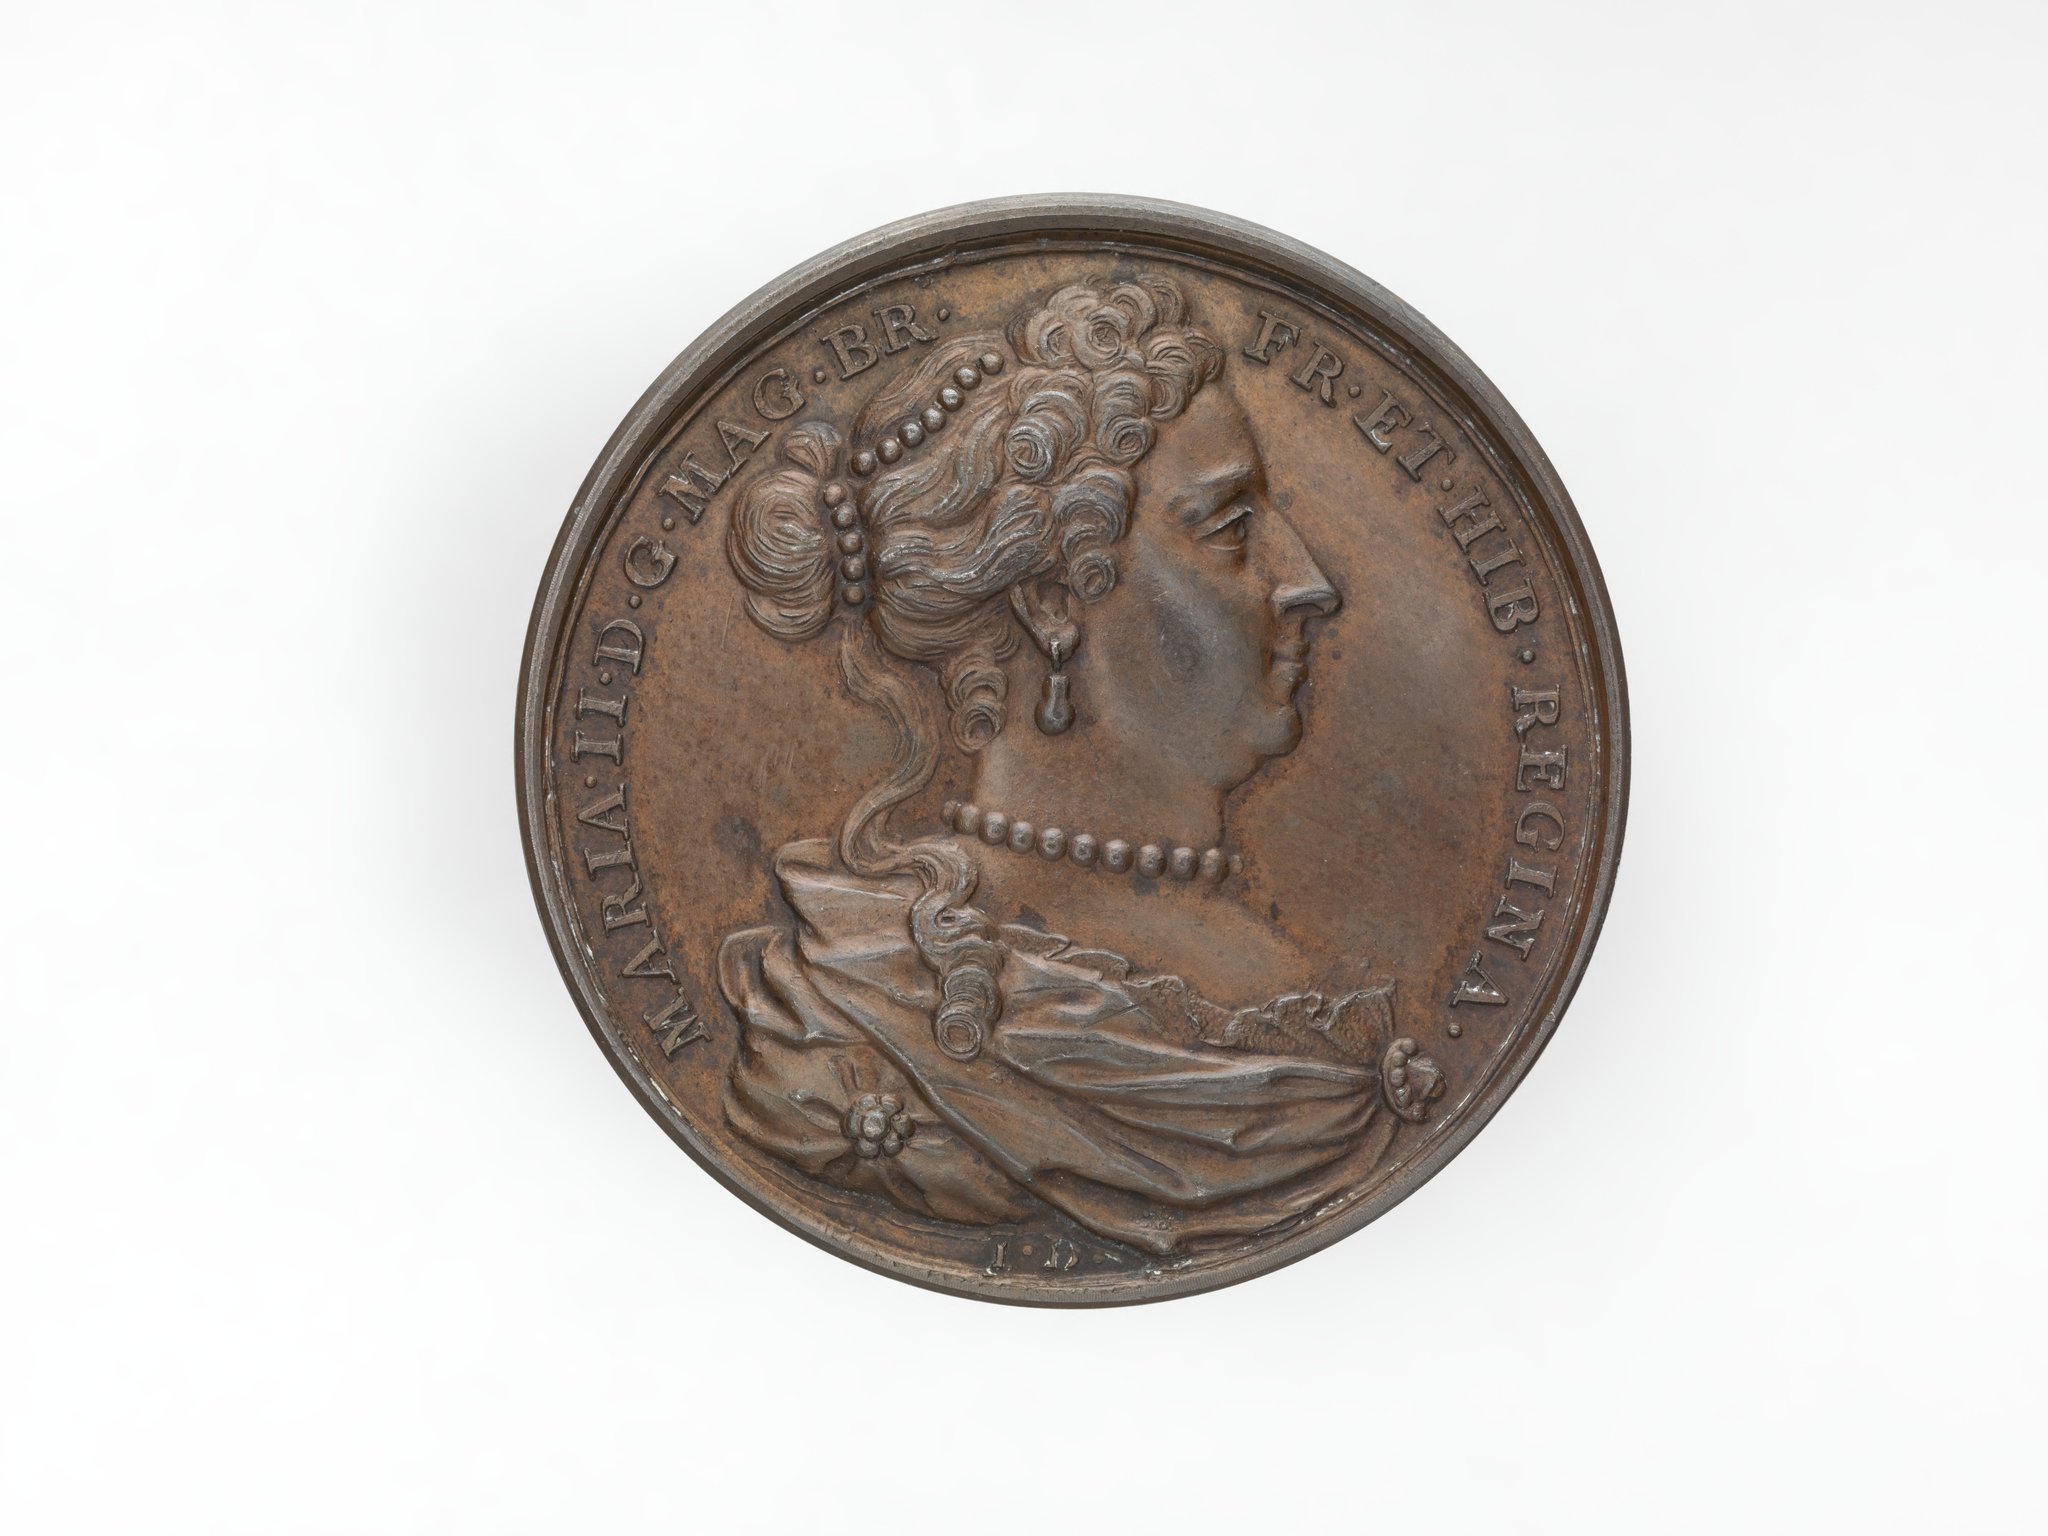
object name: medal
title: Mary II, from the English Monarchs series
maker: jean dassier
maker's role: artist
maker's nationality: swiss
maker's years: 1676-1763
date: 1731-1732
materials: bronze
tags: profiles,women